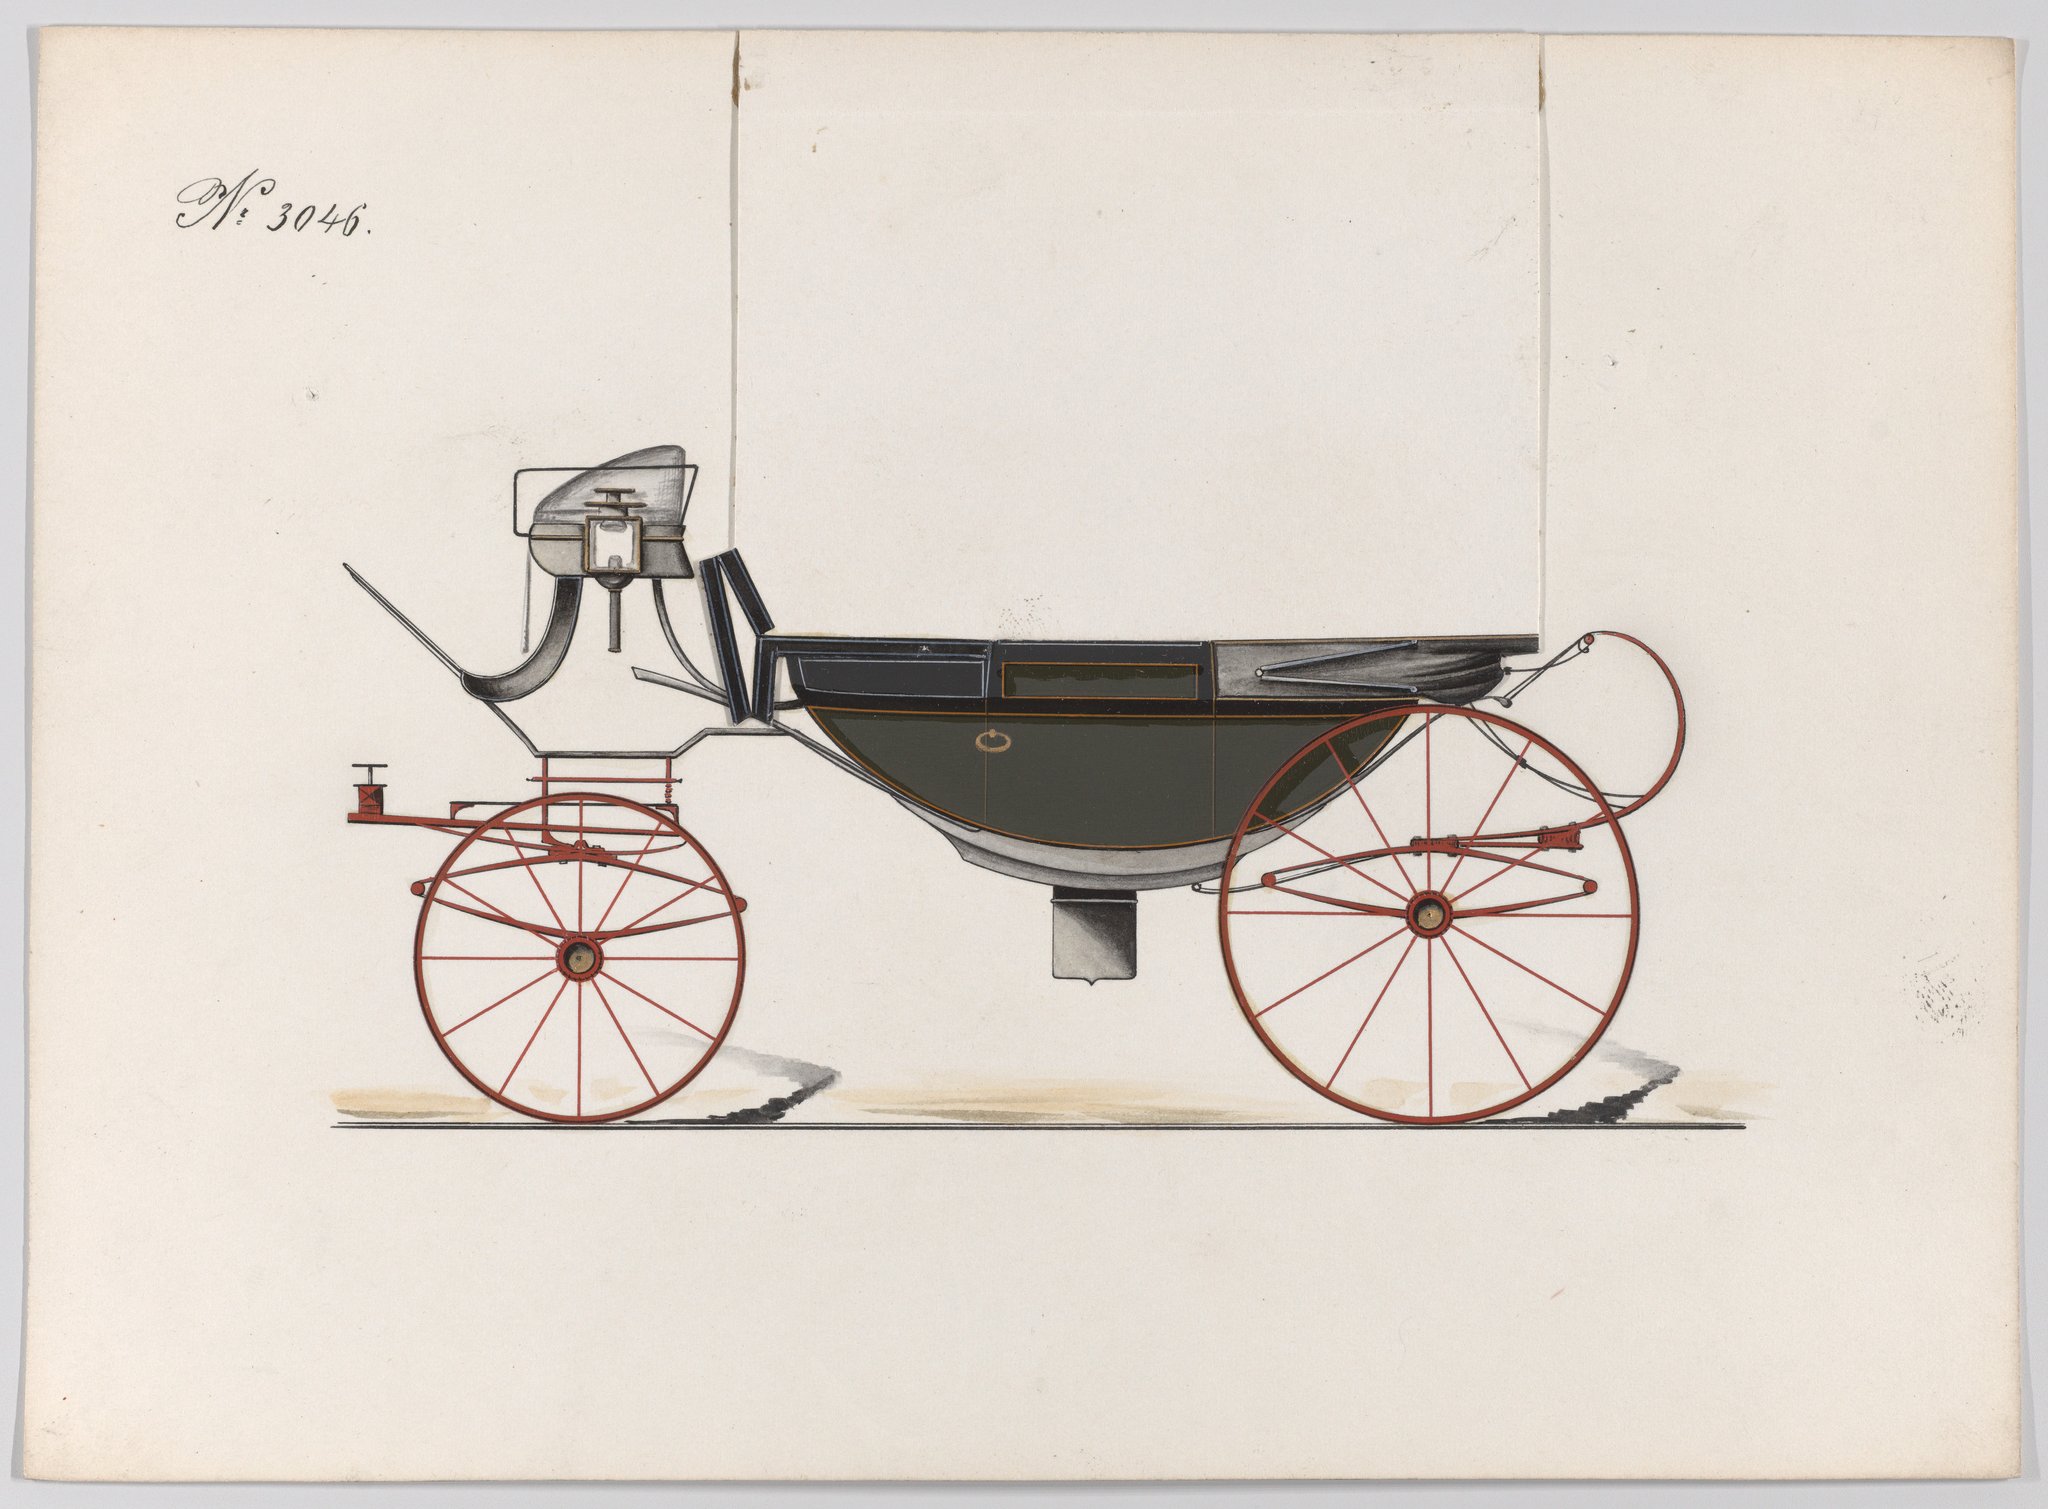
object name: drawing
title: Design for Landau, No. 3046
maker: brewster & co.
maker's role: manufacturer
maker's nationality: american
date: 1874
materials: gouache, gum arabic, ink, watercolor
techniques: pen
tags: carriages